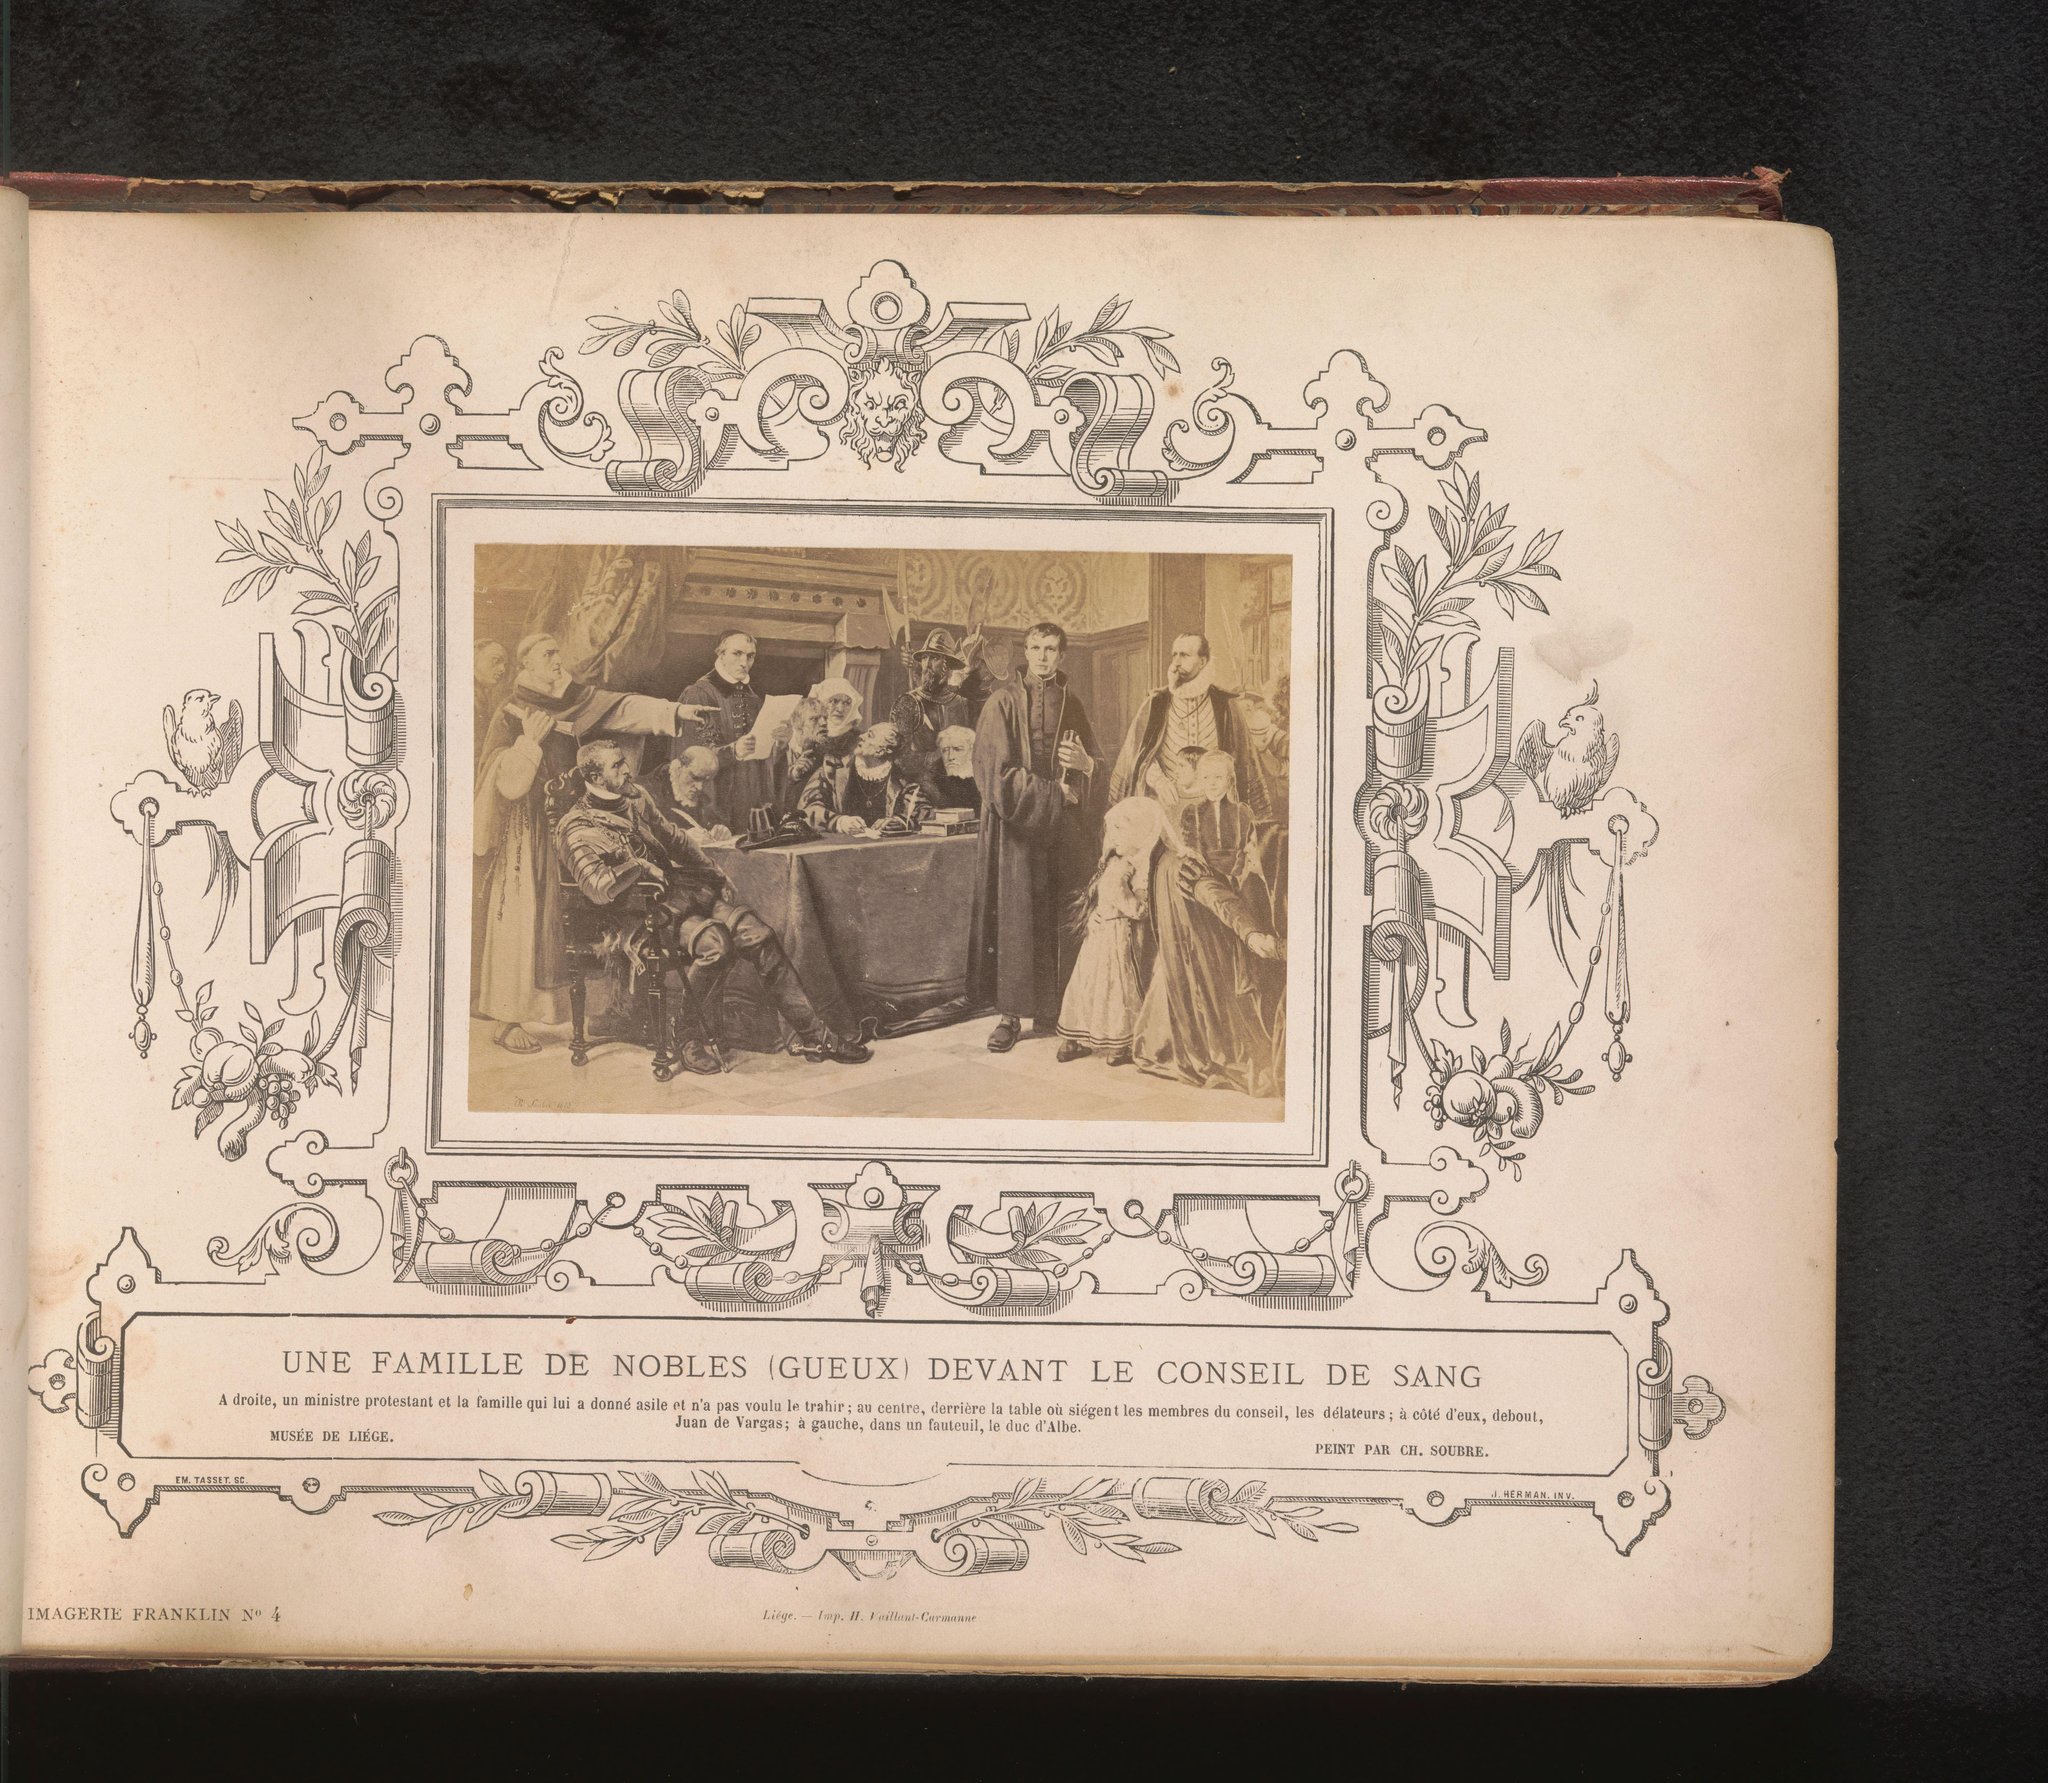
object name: reproduction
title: Une Famille de Nobles (Gueux) devant le Conseil de Sang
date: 1871-1880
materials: photographic support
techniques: albumen print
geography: liège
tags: fernando álvarez de toledo (3rd duke of alba), political tribunal (+ court room)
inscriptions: name: ‘EM. TASSET, SC.’, inscription: ‘A droite, un ministre protestant et la famille qui lui a donné asile et n'a pas voulu le trahir ; au centre, derrière la table où siégent les membres de conseil, les délateurs ; à côté d'eux, debout, / Juan de Vargas ; à gauche, dans un fauteuil, le duc d'Albe./ MUSÉE DE LIÈGE.’, inscription: ‘IMAGERIE FRANKLIN No 4.’, name: ‘J. HERMAN, INV.’